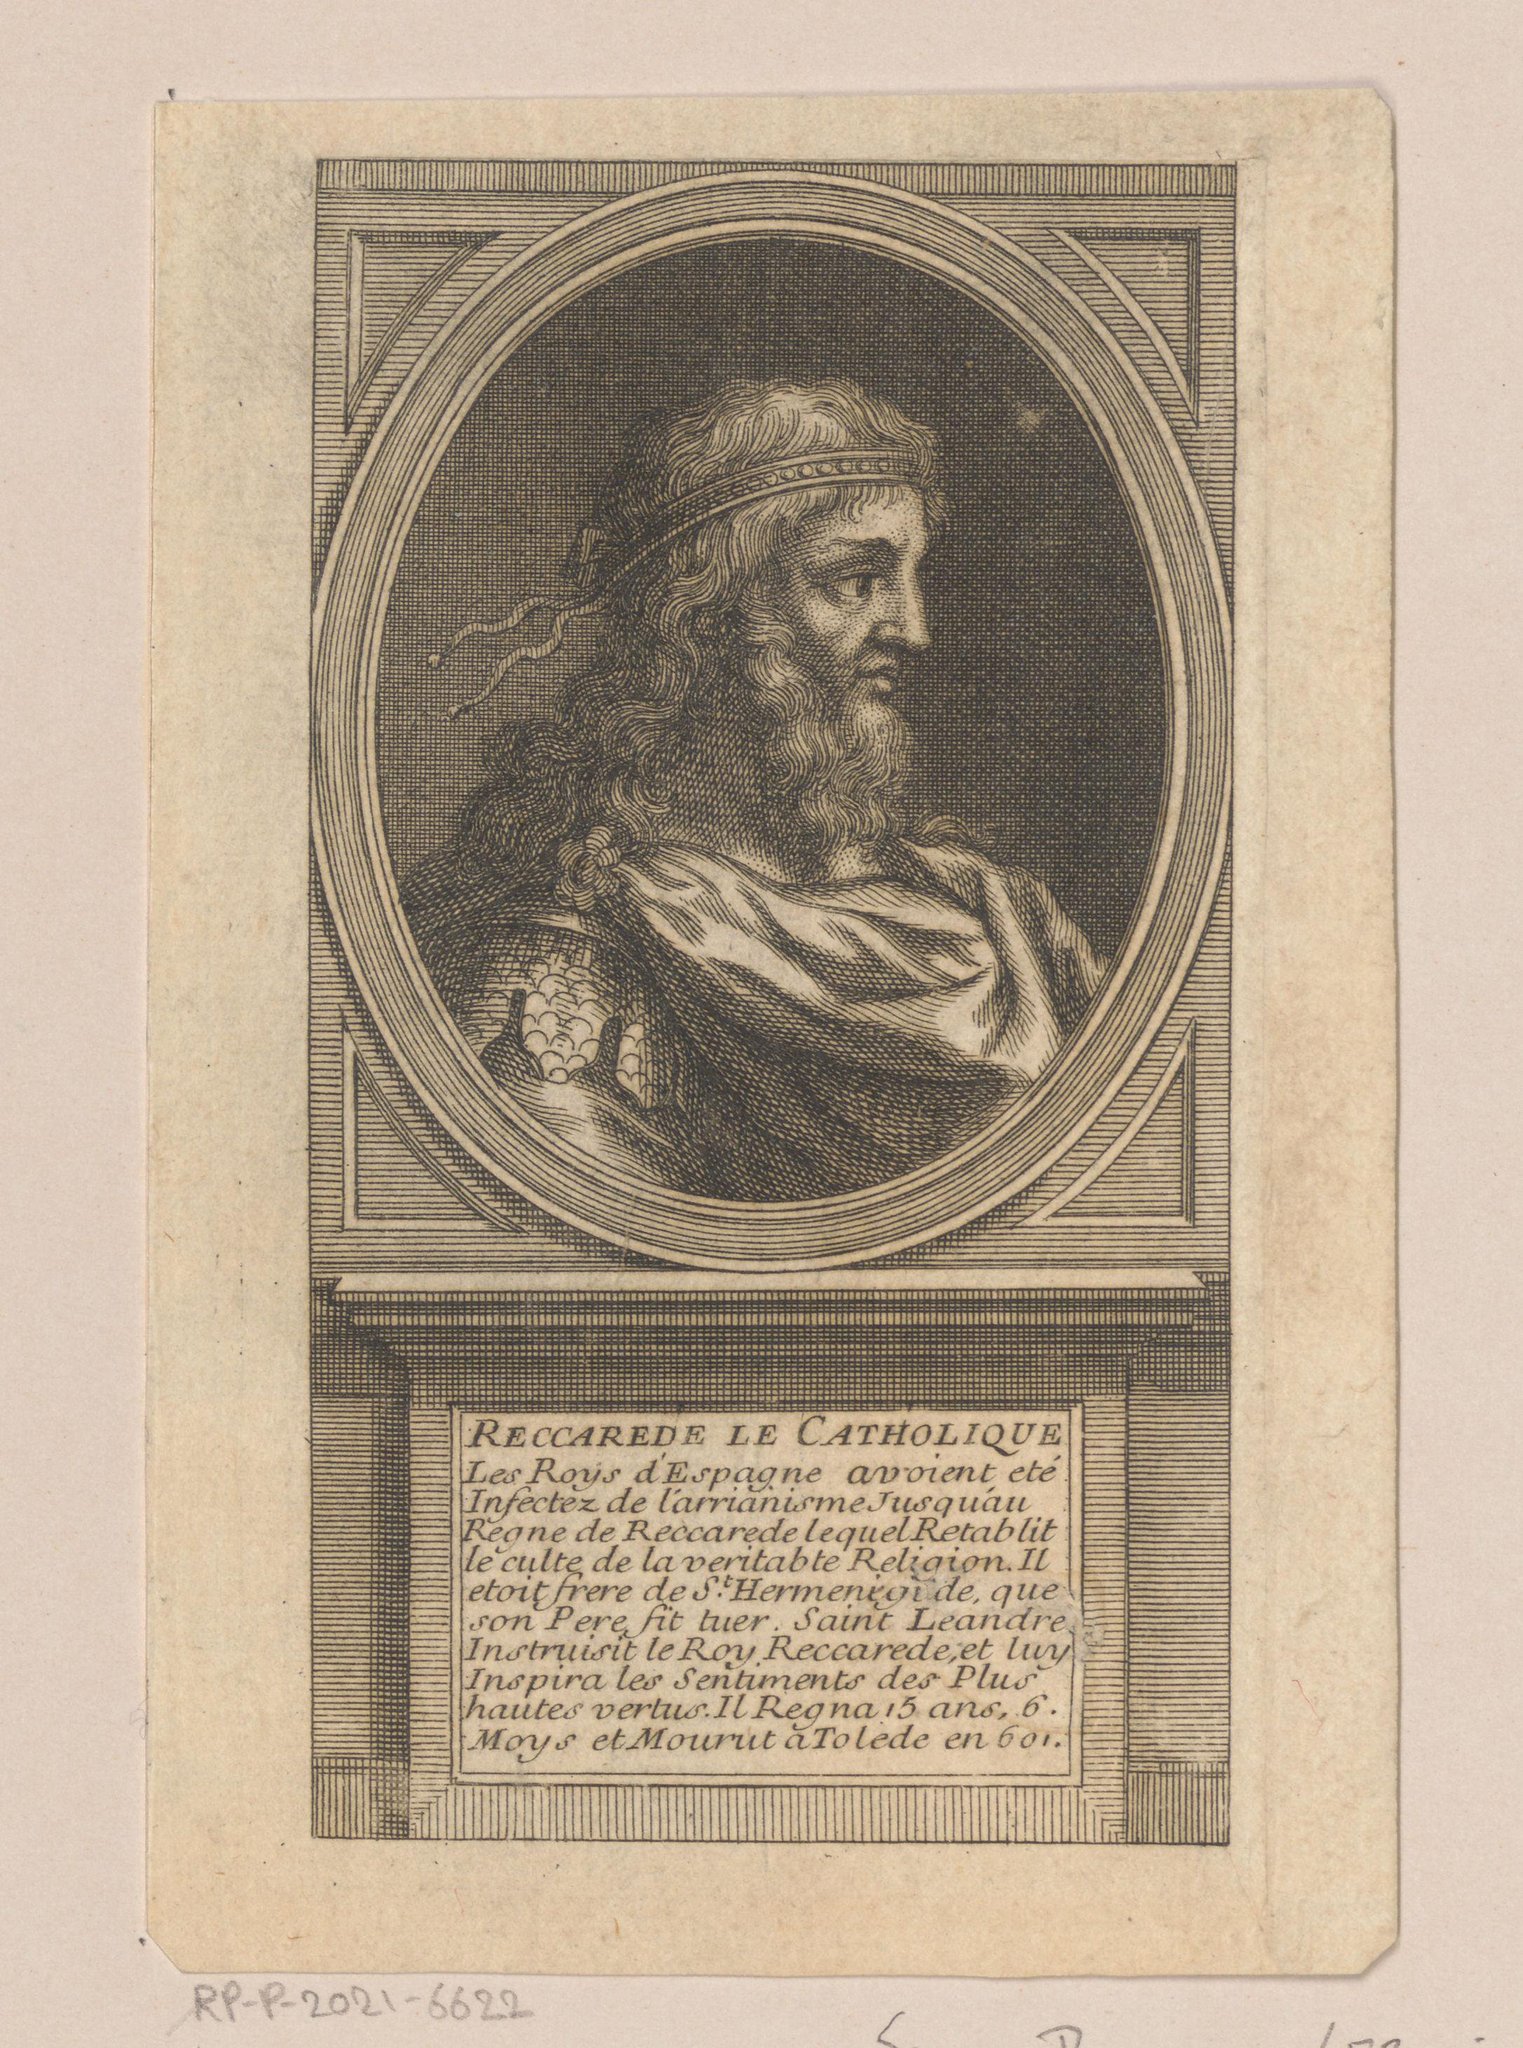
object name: print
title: Portret van Reccared I, koning van Visigoten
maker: Anonymous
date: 1723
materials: paper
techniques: engraving, etching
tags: historical persons, king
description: Prent mogelijk uit: Histoire générale d'Espagne, depuis le commencement de la monarchie jusqu'à présent (...). Parijs: André Pralard, 1723, dl. 2.